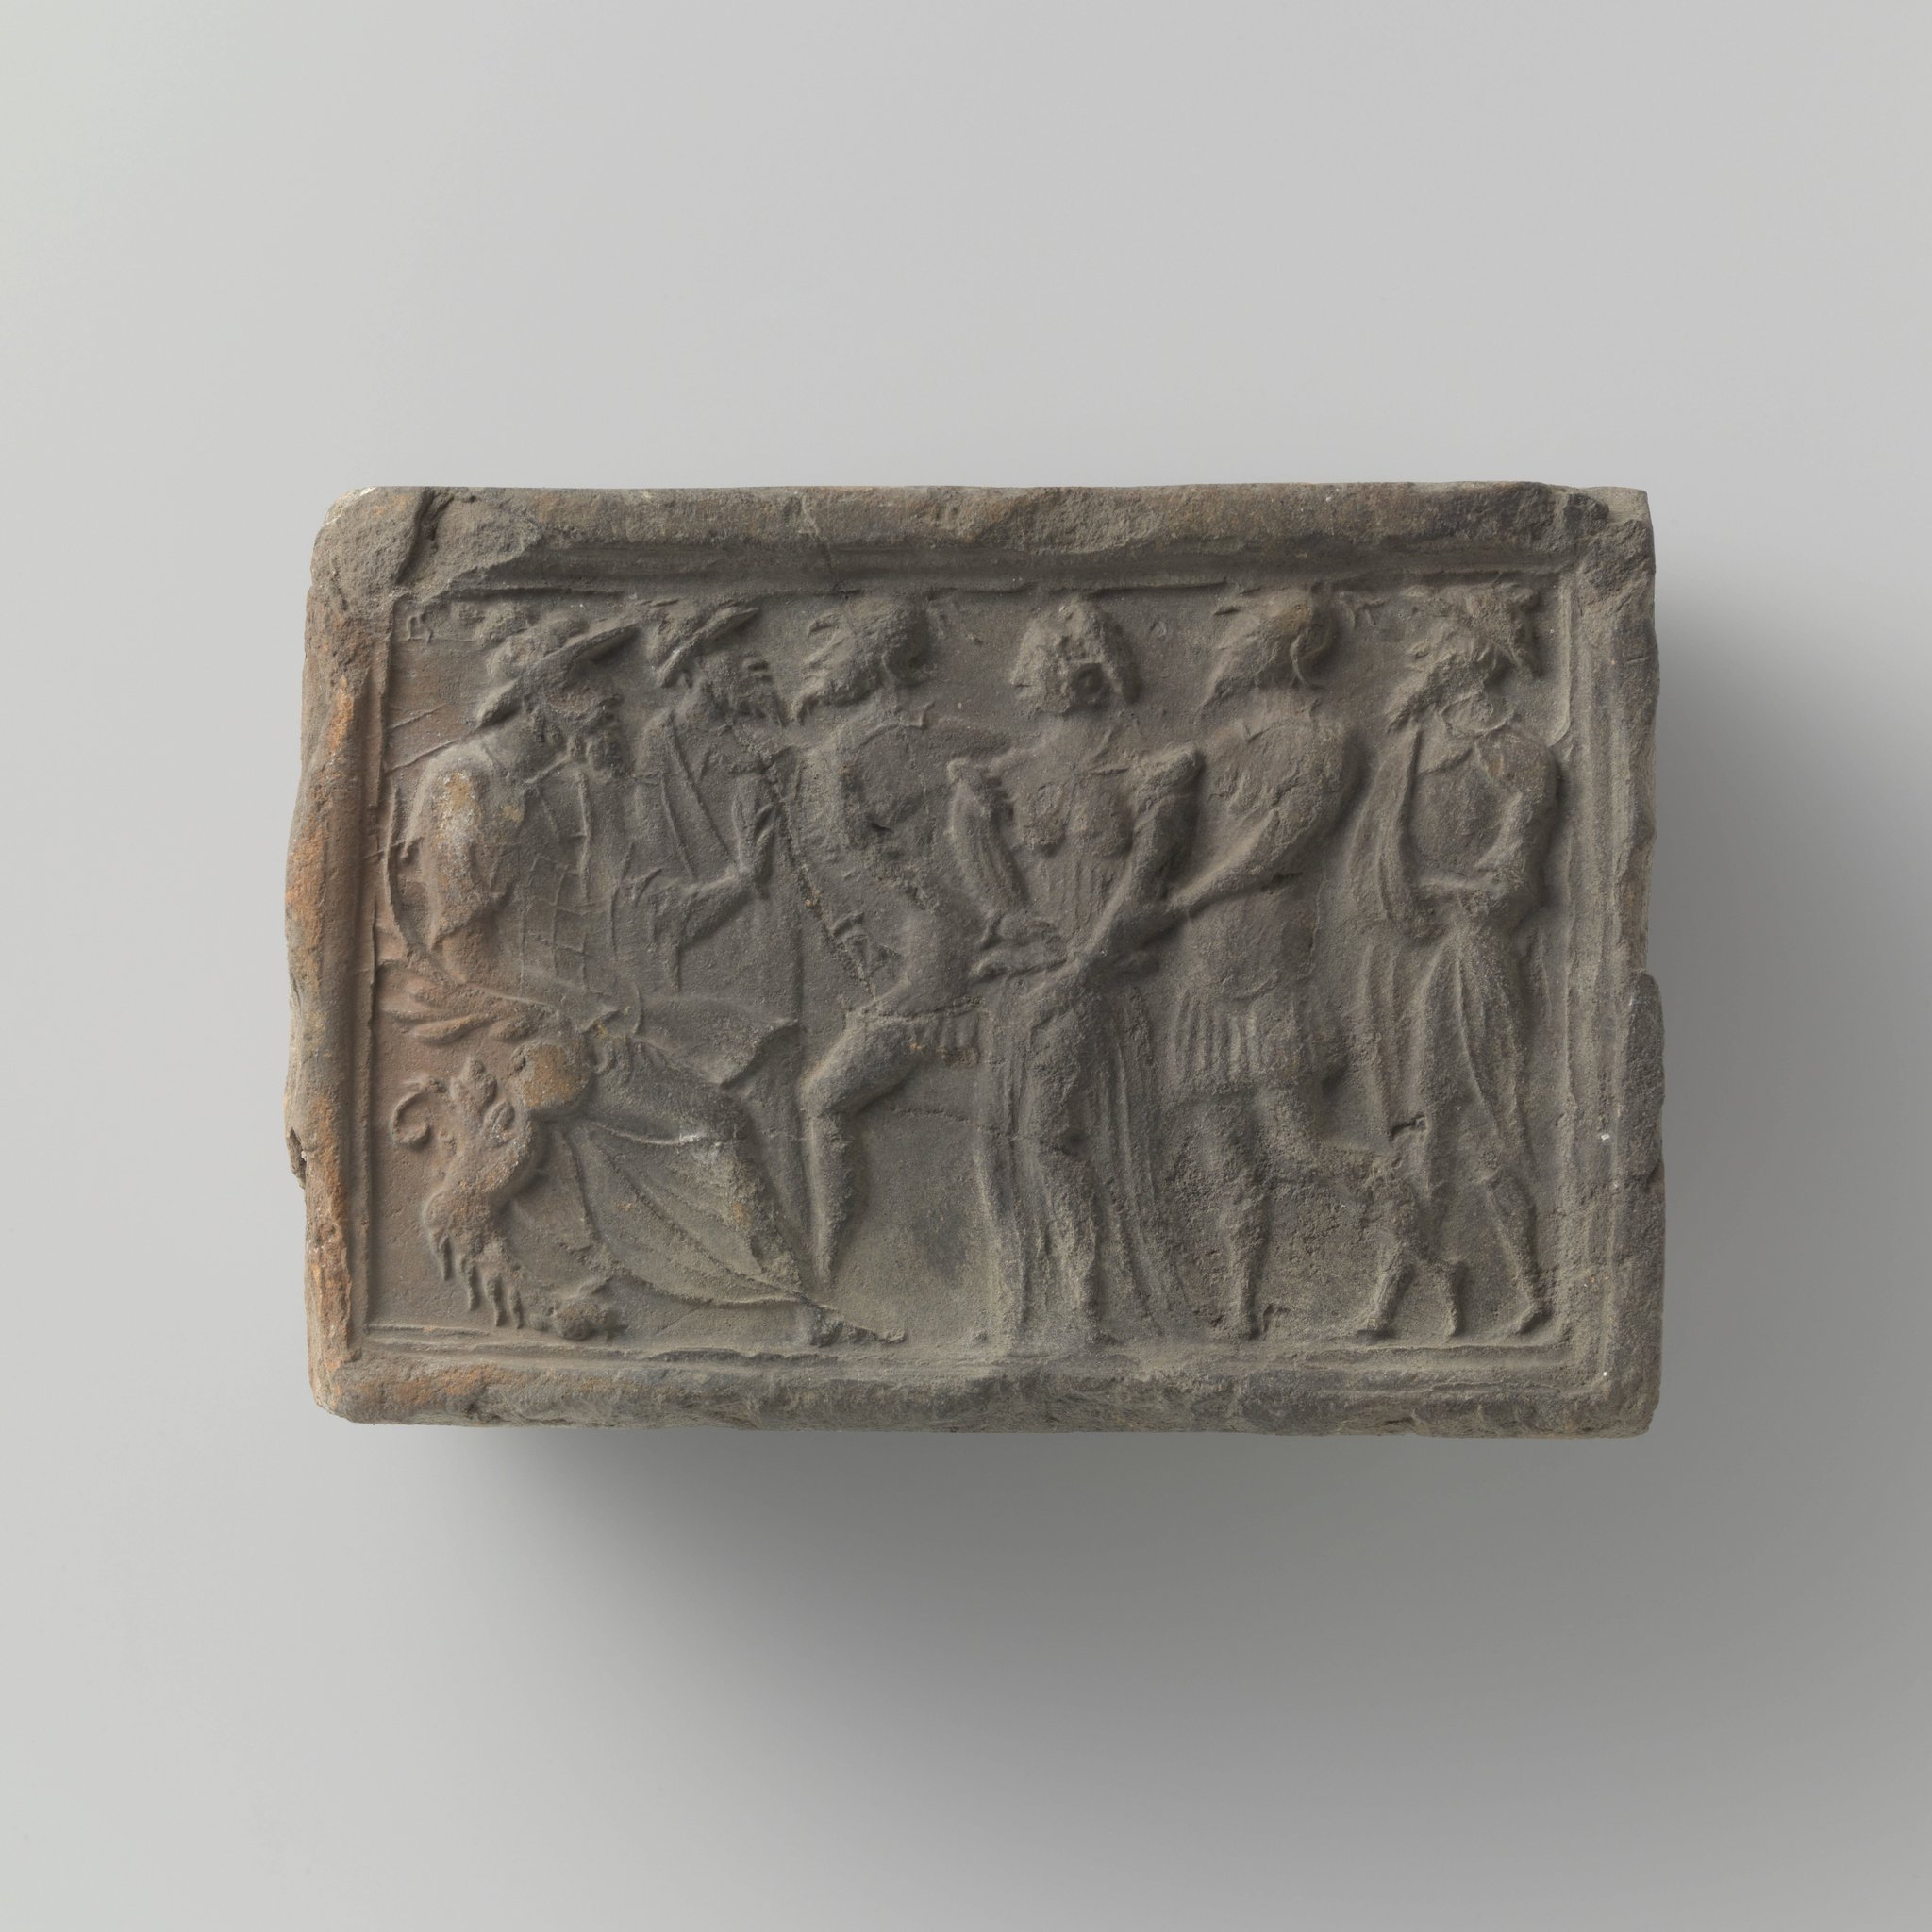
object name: hearthstone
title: Haardsteen met voorstelling van Suzanna, die door de twee ouderlingen voor de rechter wordt gevoerd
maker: Anonymous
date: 1400-1950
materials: earthenware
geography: southern netherlands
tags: the elders accusing susanna before the people, laying their hands on her head or unveiling her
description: Haardsteen met voorstelling van Suzanna, die door de twee ouderlingen voor de rechter wordt gevoerd.